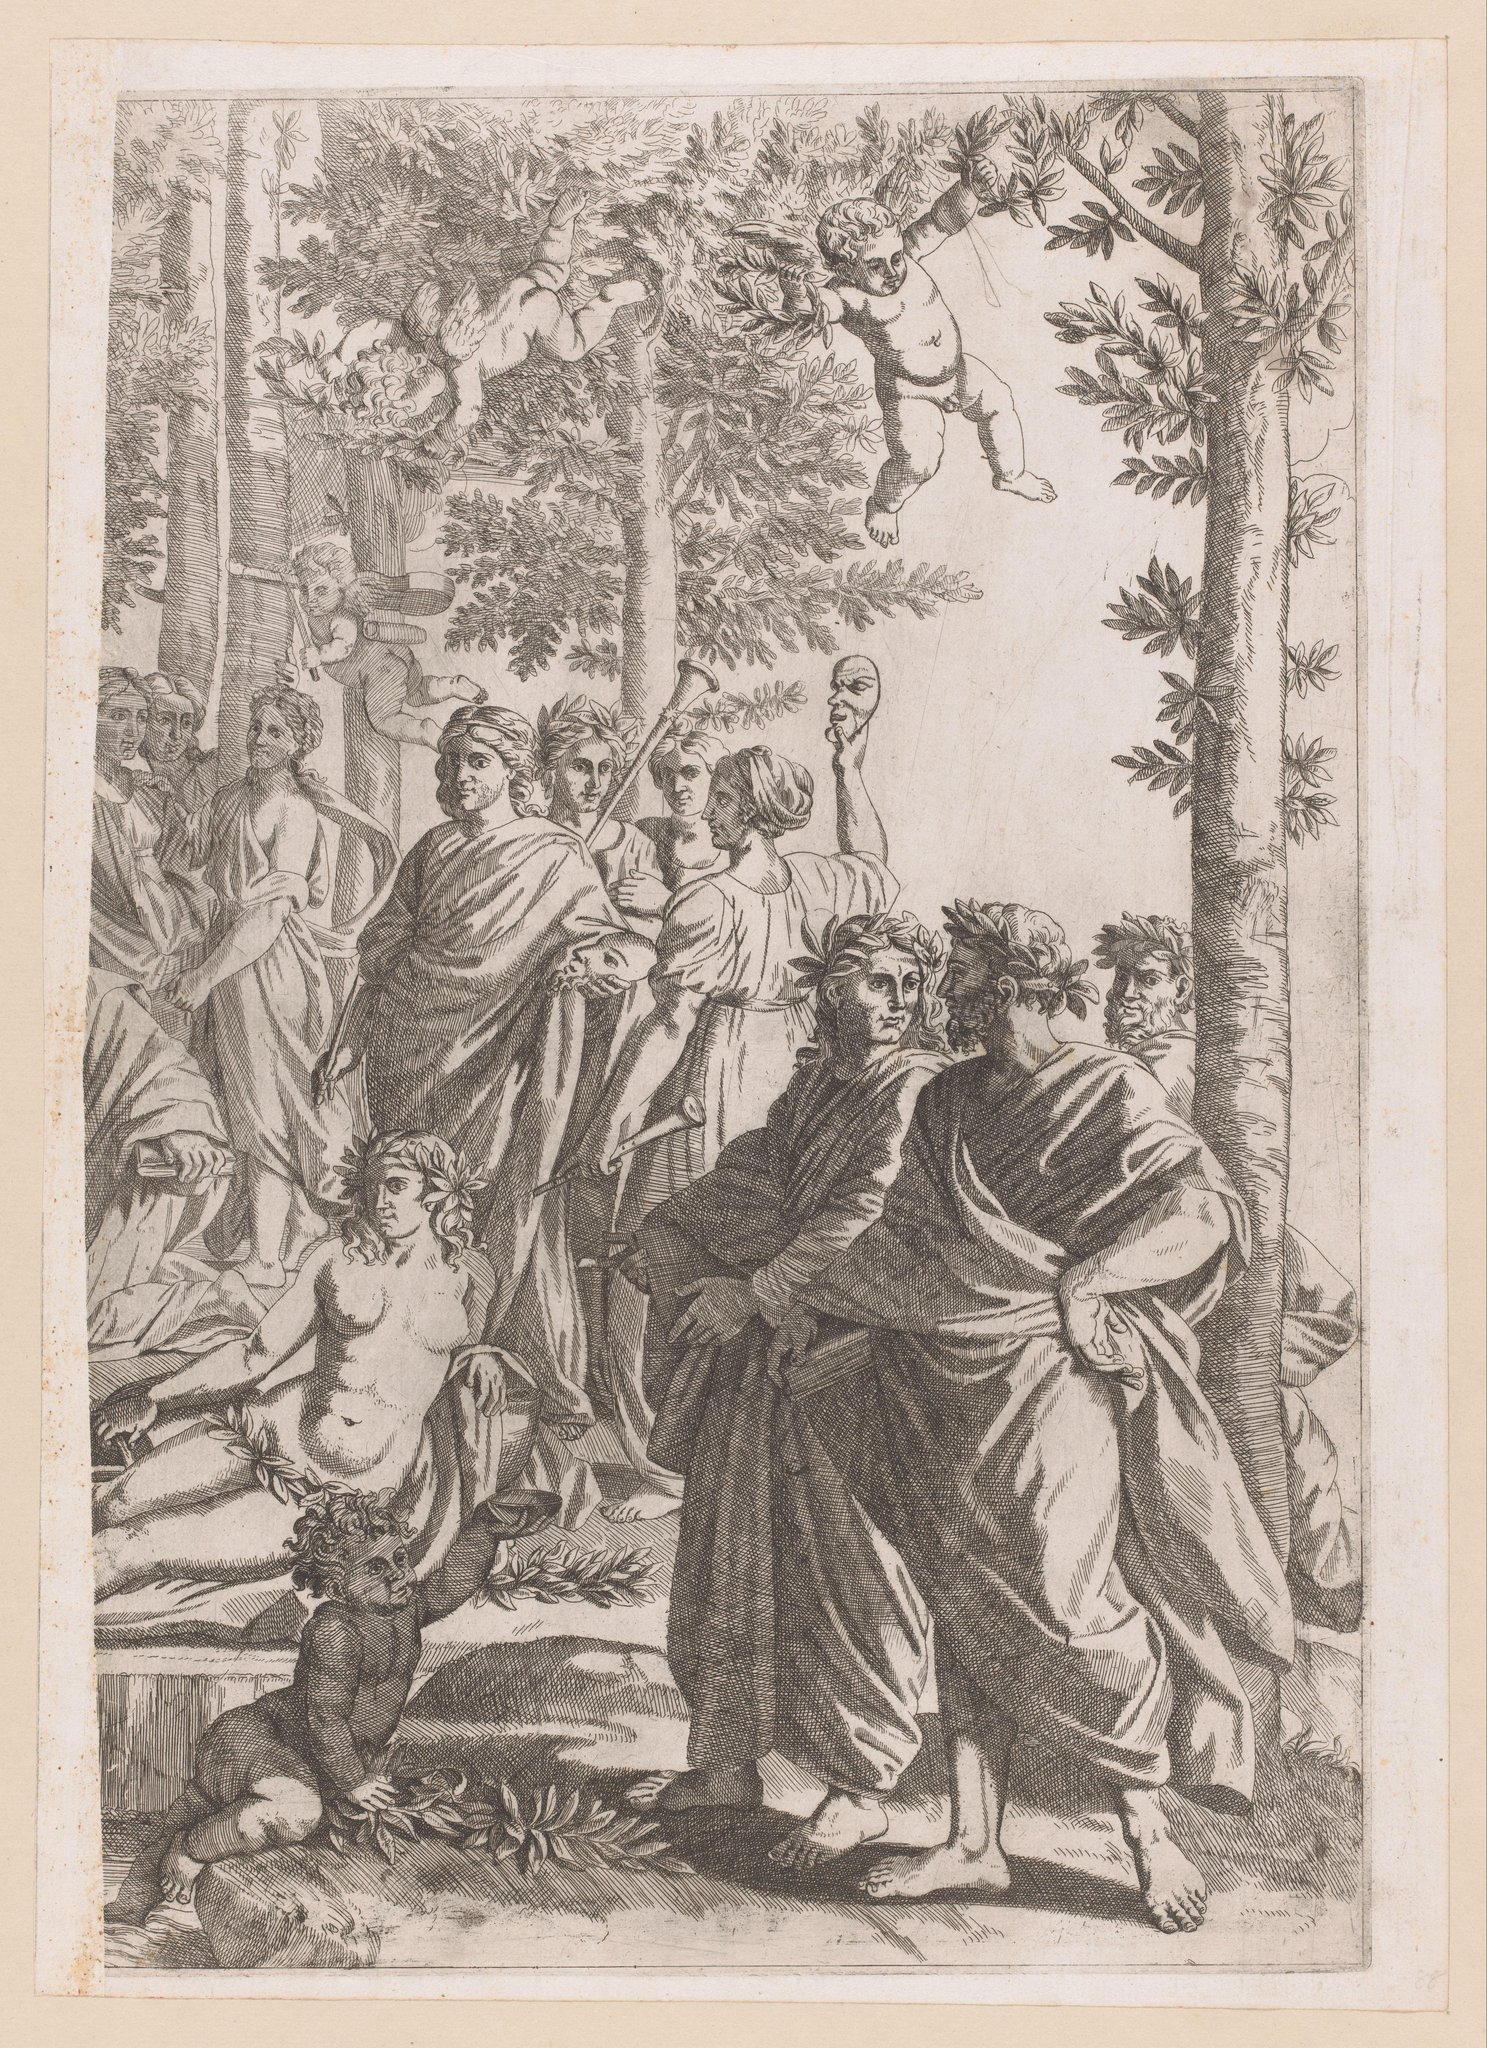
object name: print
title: Gelauwerde mannen en vrouwen bijeen in een bos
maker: Anonymous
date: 1600-1699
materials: paper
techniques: etching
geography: france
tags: honouring the artist with laurel wreath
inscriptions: collector's mark: Lugt 240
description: Betreft mogelijk het rechterdeel van een groter geheel.